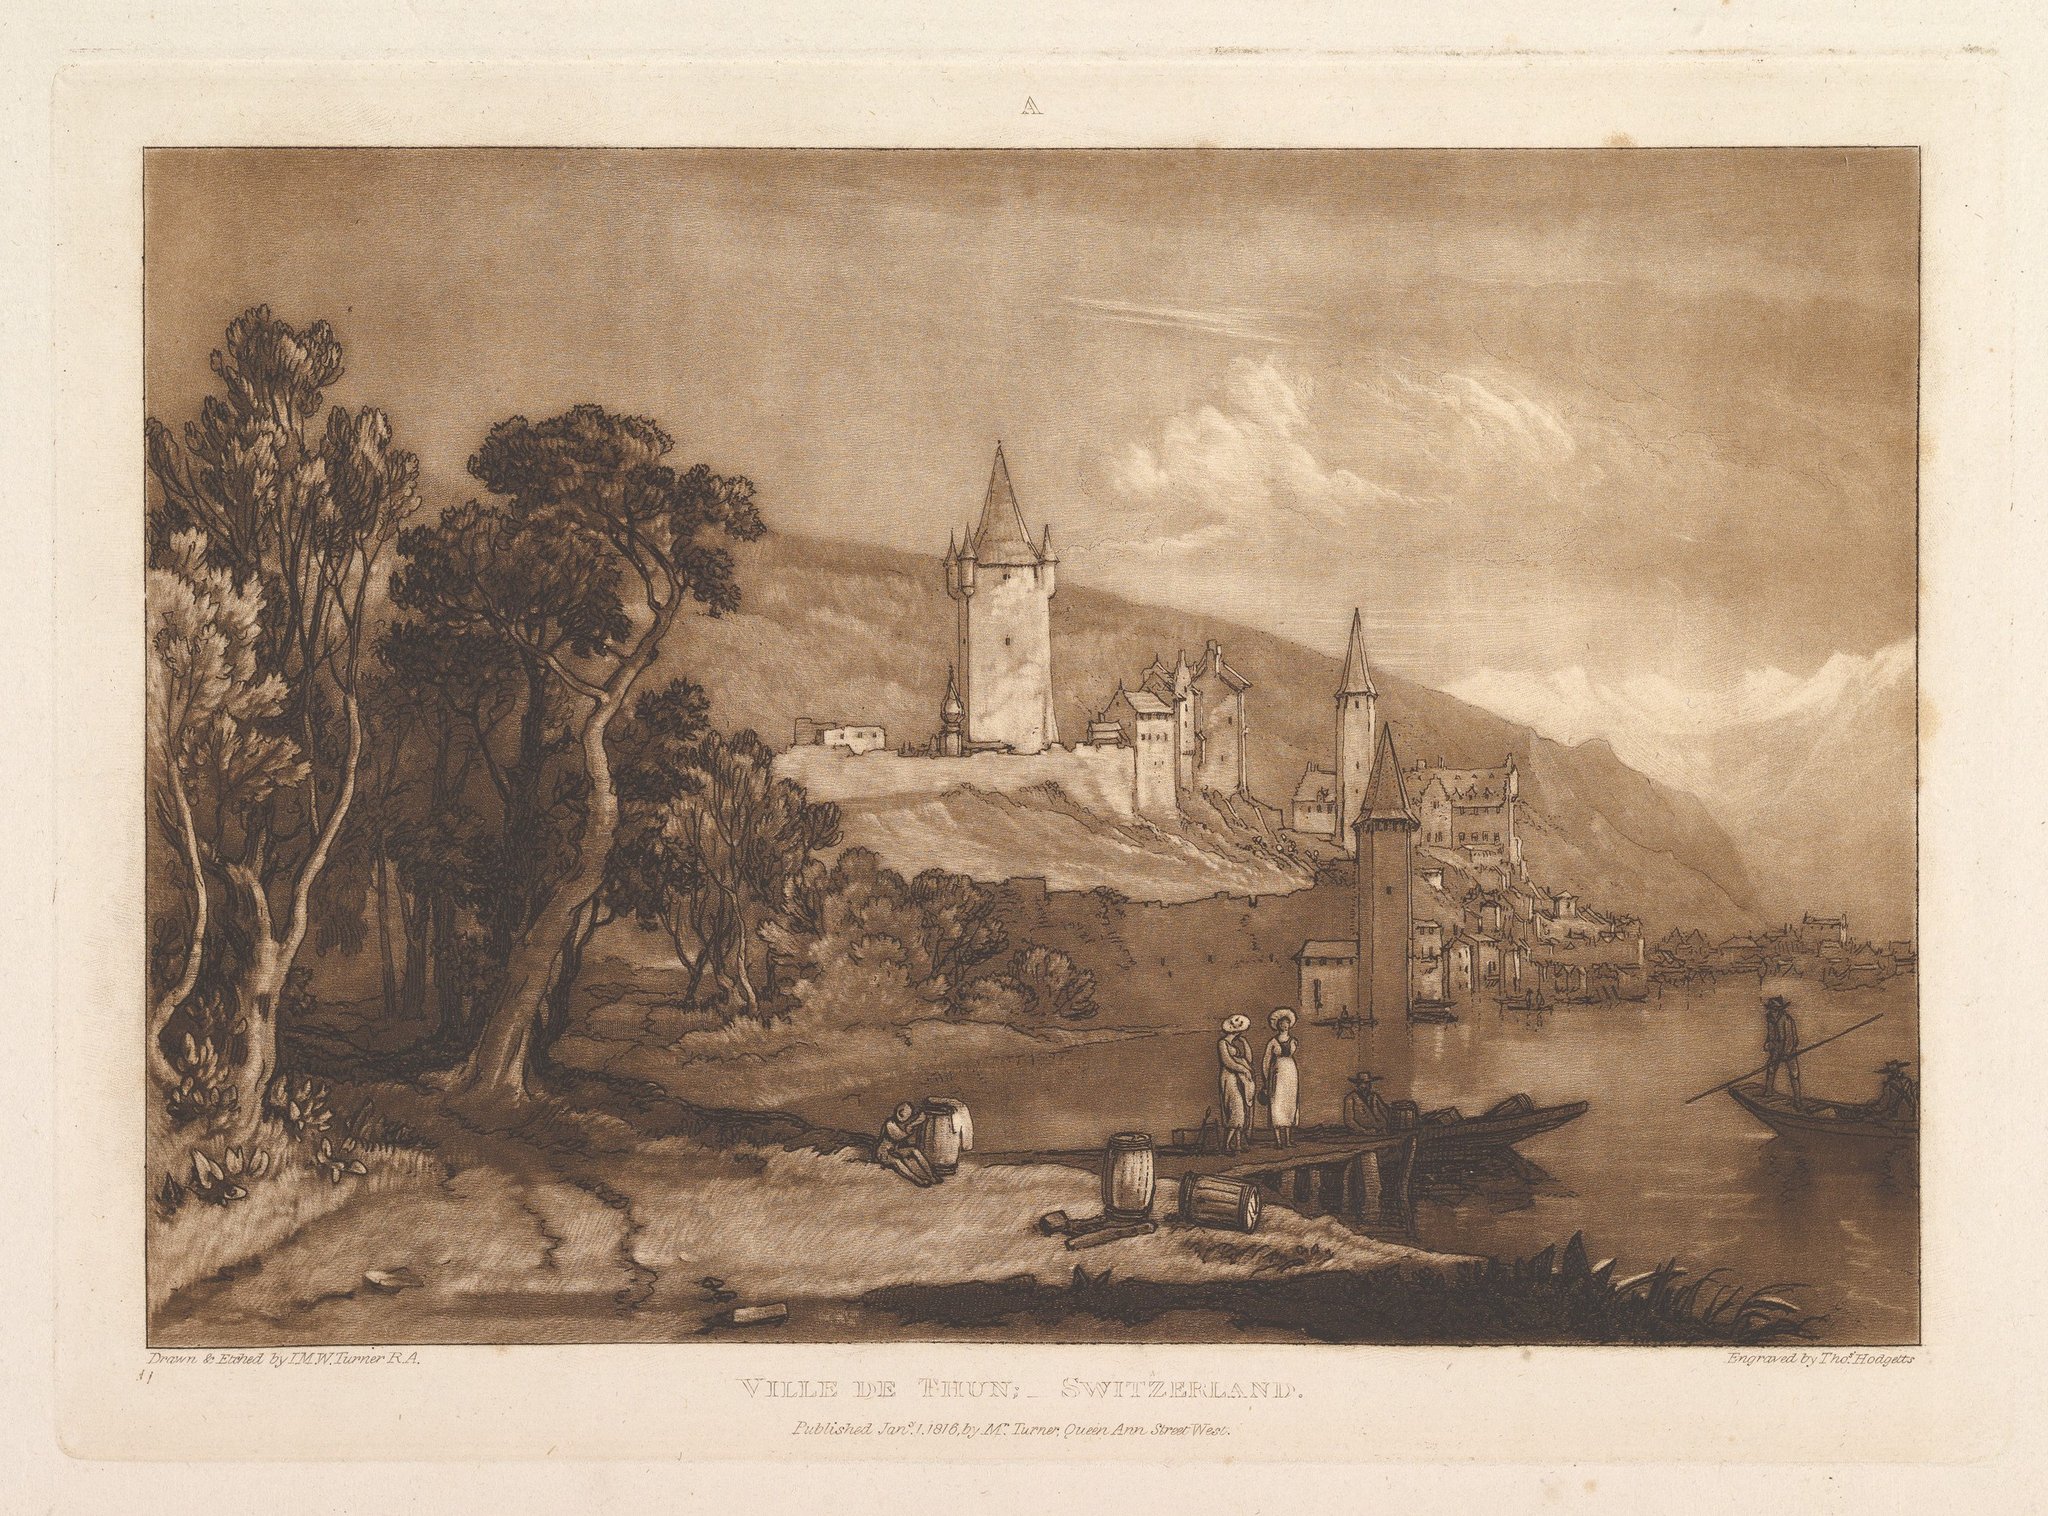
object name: print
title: Ville de Thun, Switzerland (Liber Studiorum, part XII, plate 59)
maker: joseph mallord william turner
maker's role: artist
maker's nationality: british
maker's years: 1775-1851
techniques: etching, mezzotint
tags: buildings,towns,women,lakes,boats